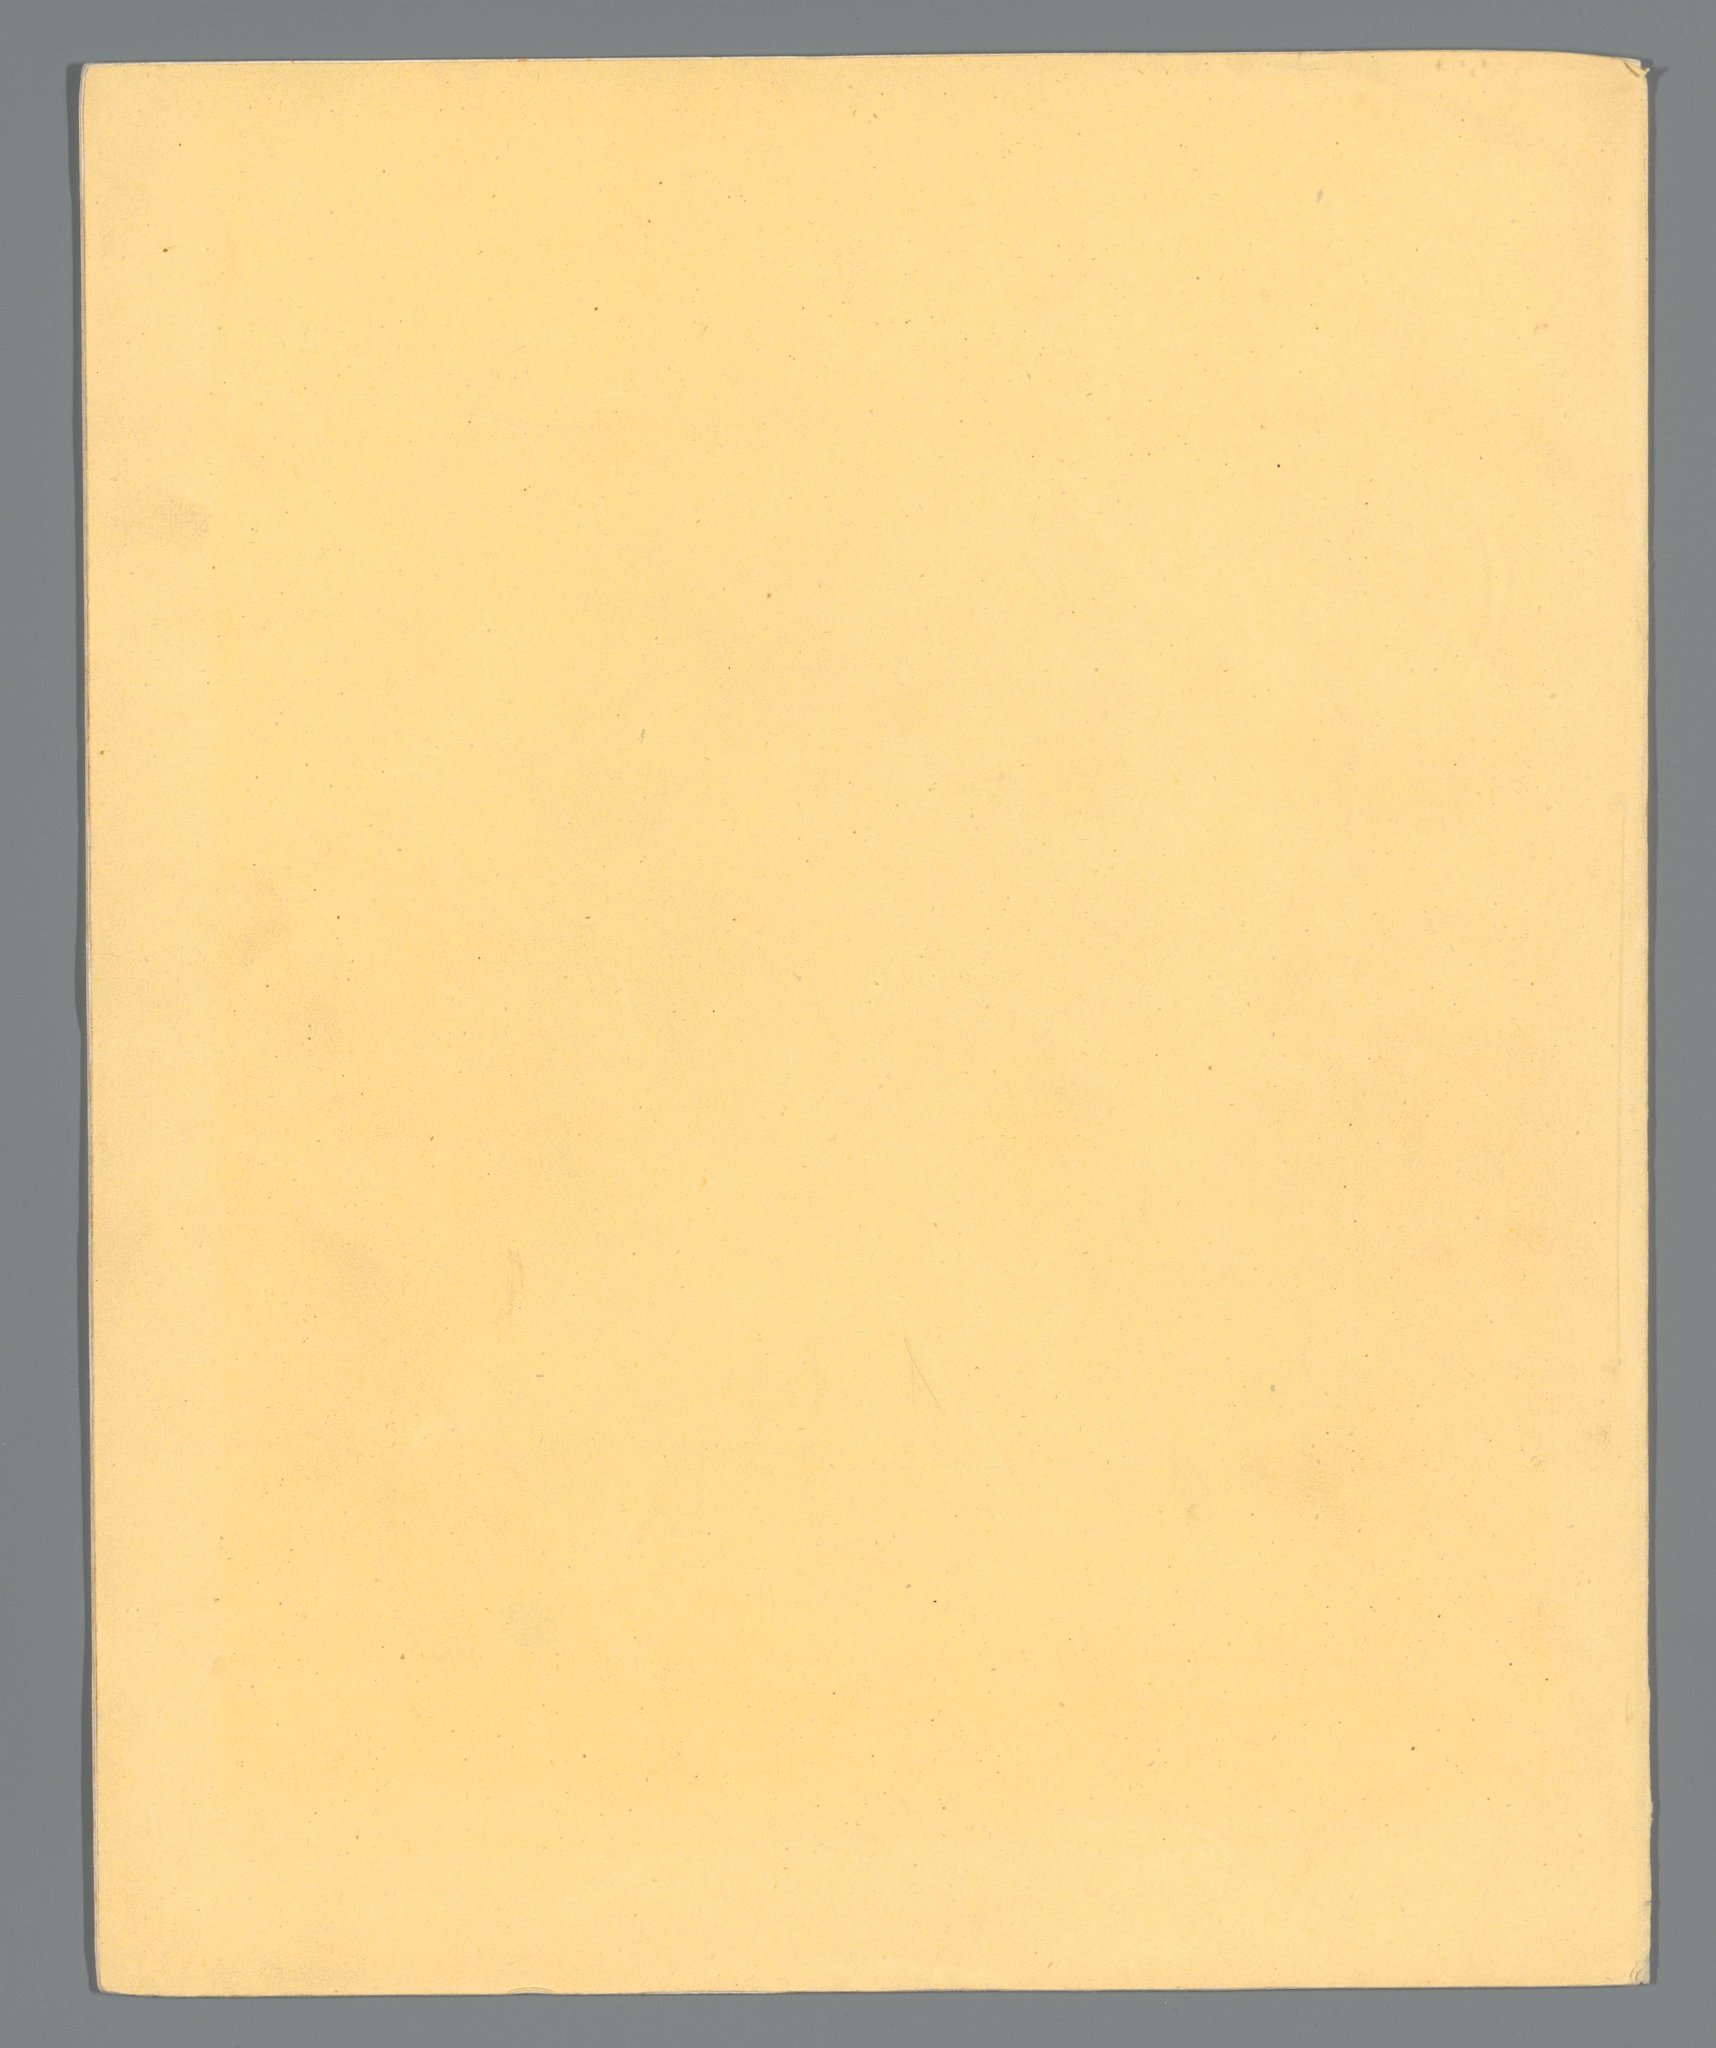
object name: book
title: 6 Landschaftliche Entwürfe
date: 1804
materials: paper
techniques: aquatint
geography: karlsruhe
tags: landscapes in the temperate zone - hh - ideal landscapes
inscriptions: collector's mark: Lugt 2760, collector's mark: Lugt 2228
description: Haldenwang, Christian. 6 Landschaftliche Entwürfe nach Wehle in Aqua tinta geätzt vom C. Haldenwang. Karlsruhe: Franz Nöldeke, [1804].